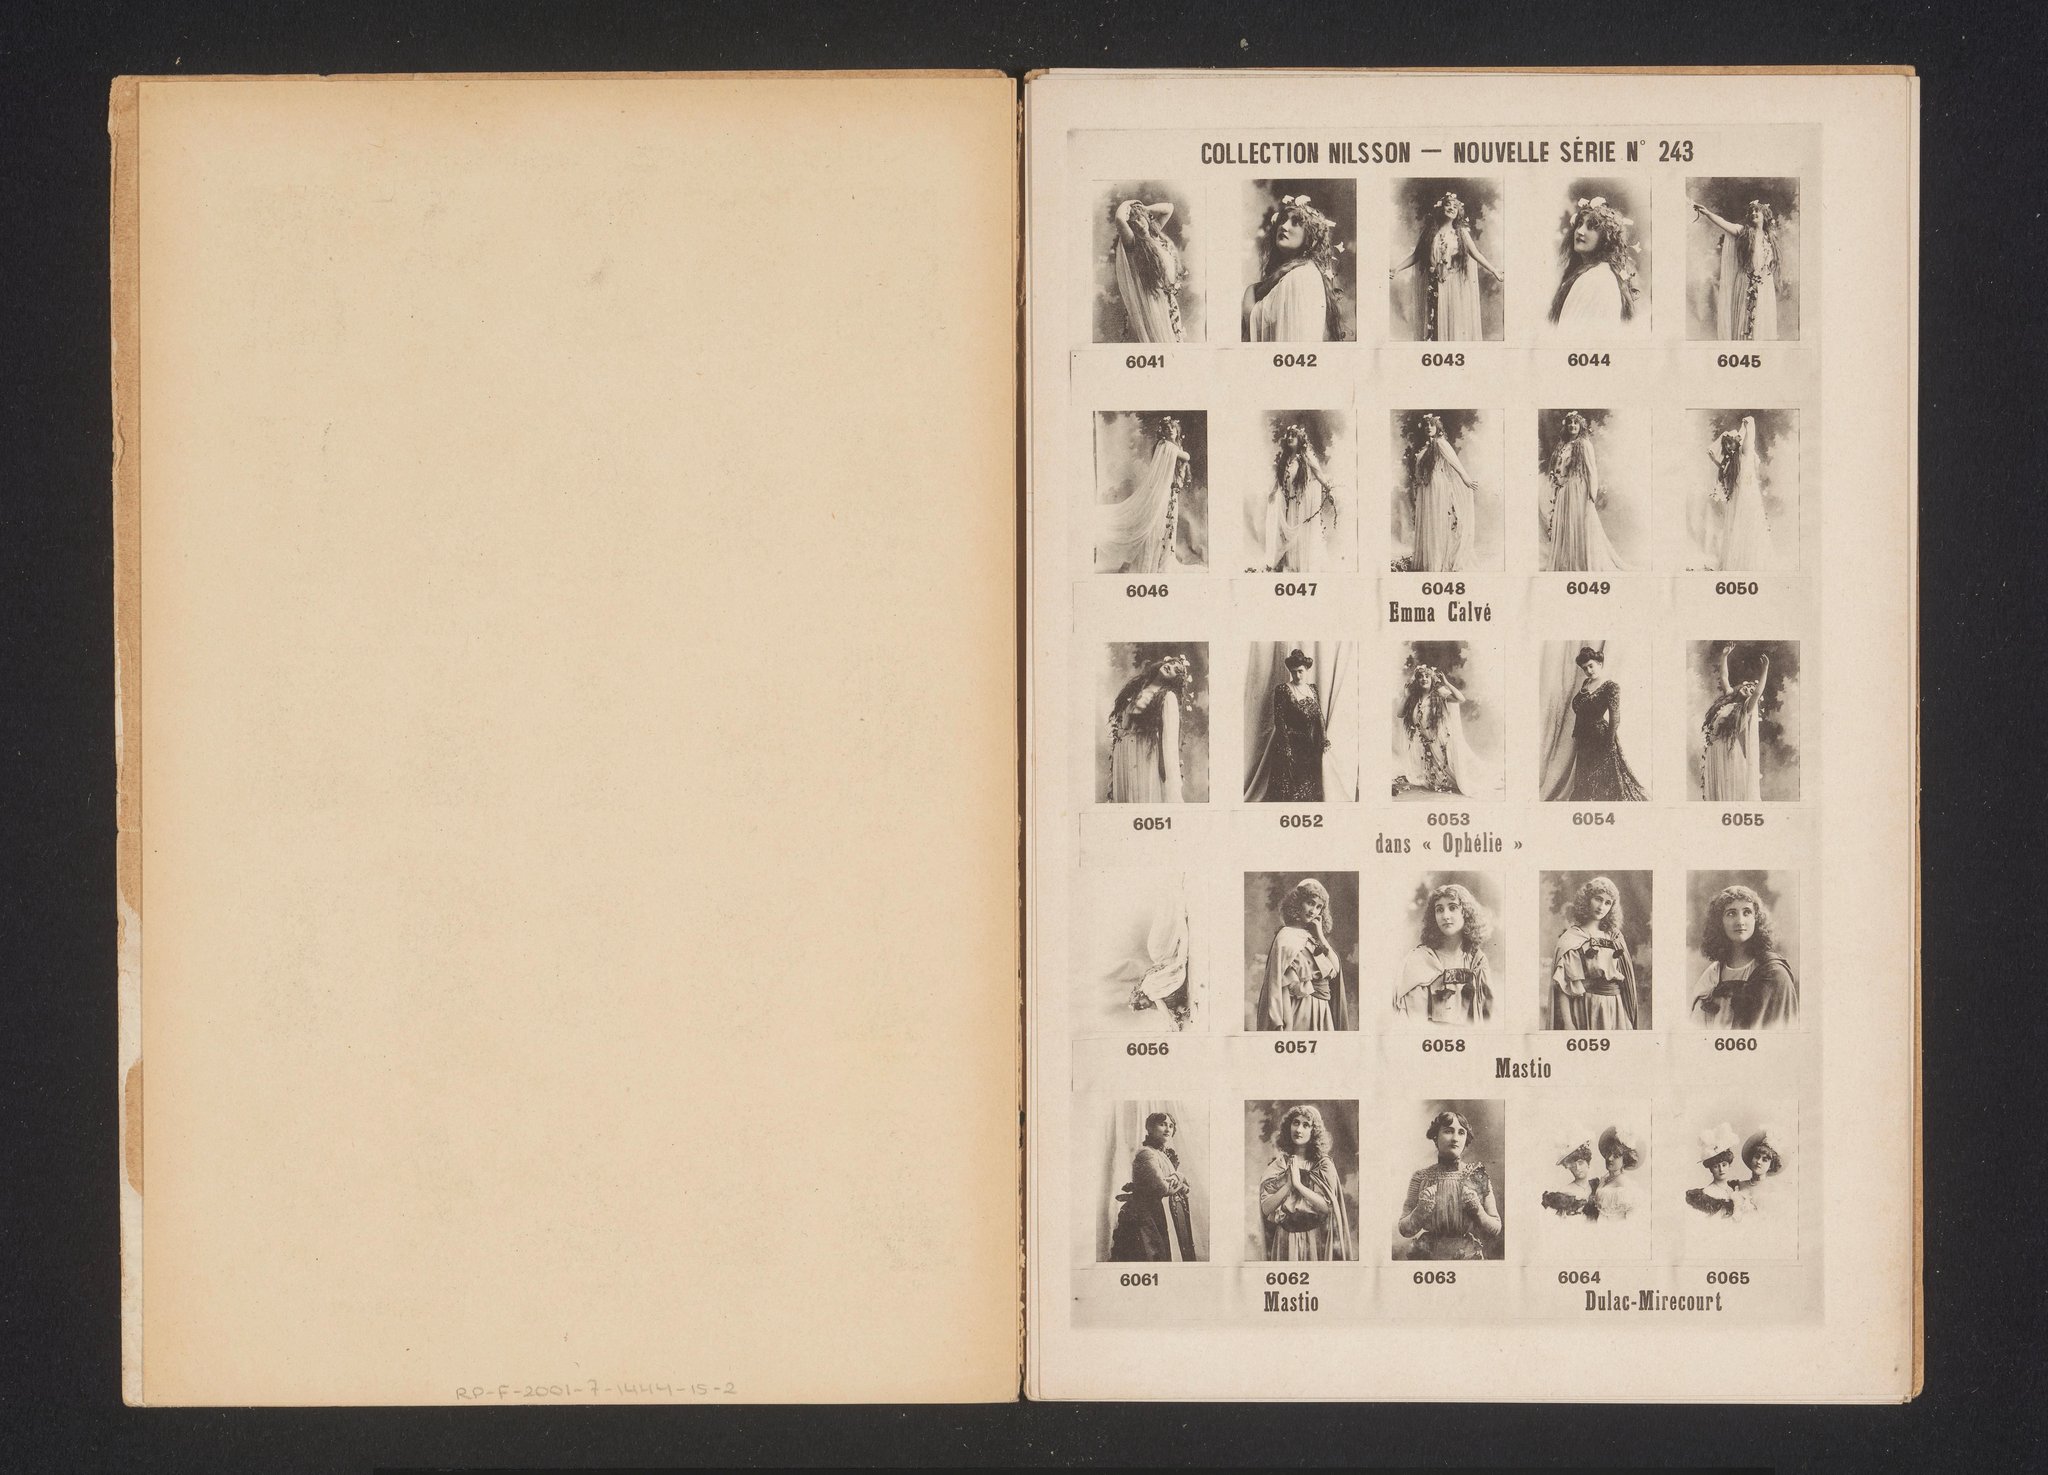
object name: photomechanical print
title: Collection Nilsson - Nouvelle Série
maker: Anonymous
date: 1894-1899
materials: paper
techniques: photograph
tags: historical persons - bb - woman, portrait of opera-singer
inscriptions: inscription: ‘Emma Calvé/ dans < < Ophélie > >/ Mastio/ Mastio Dulac-Mirecourt’, number: ‘No 243’